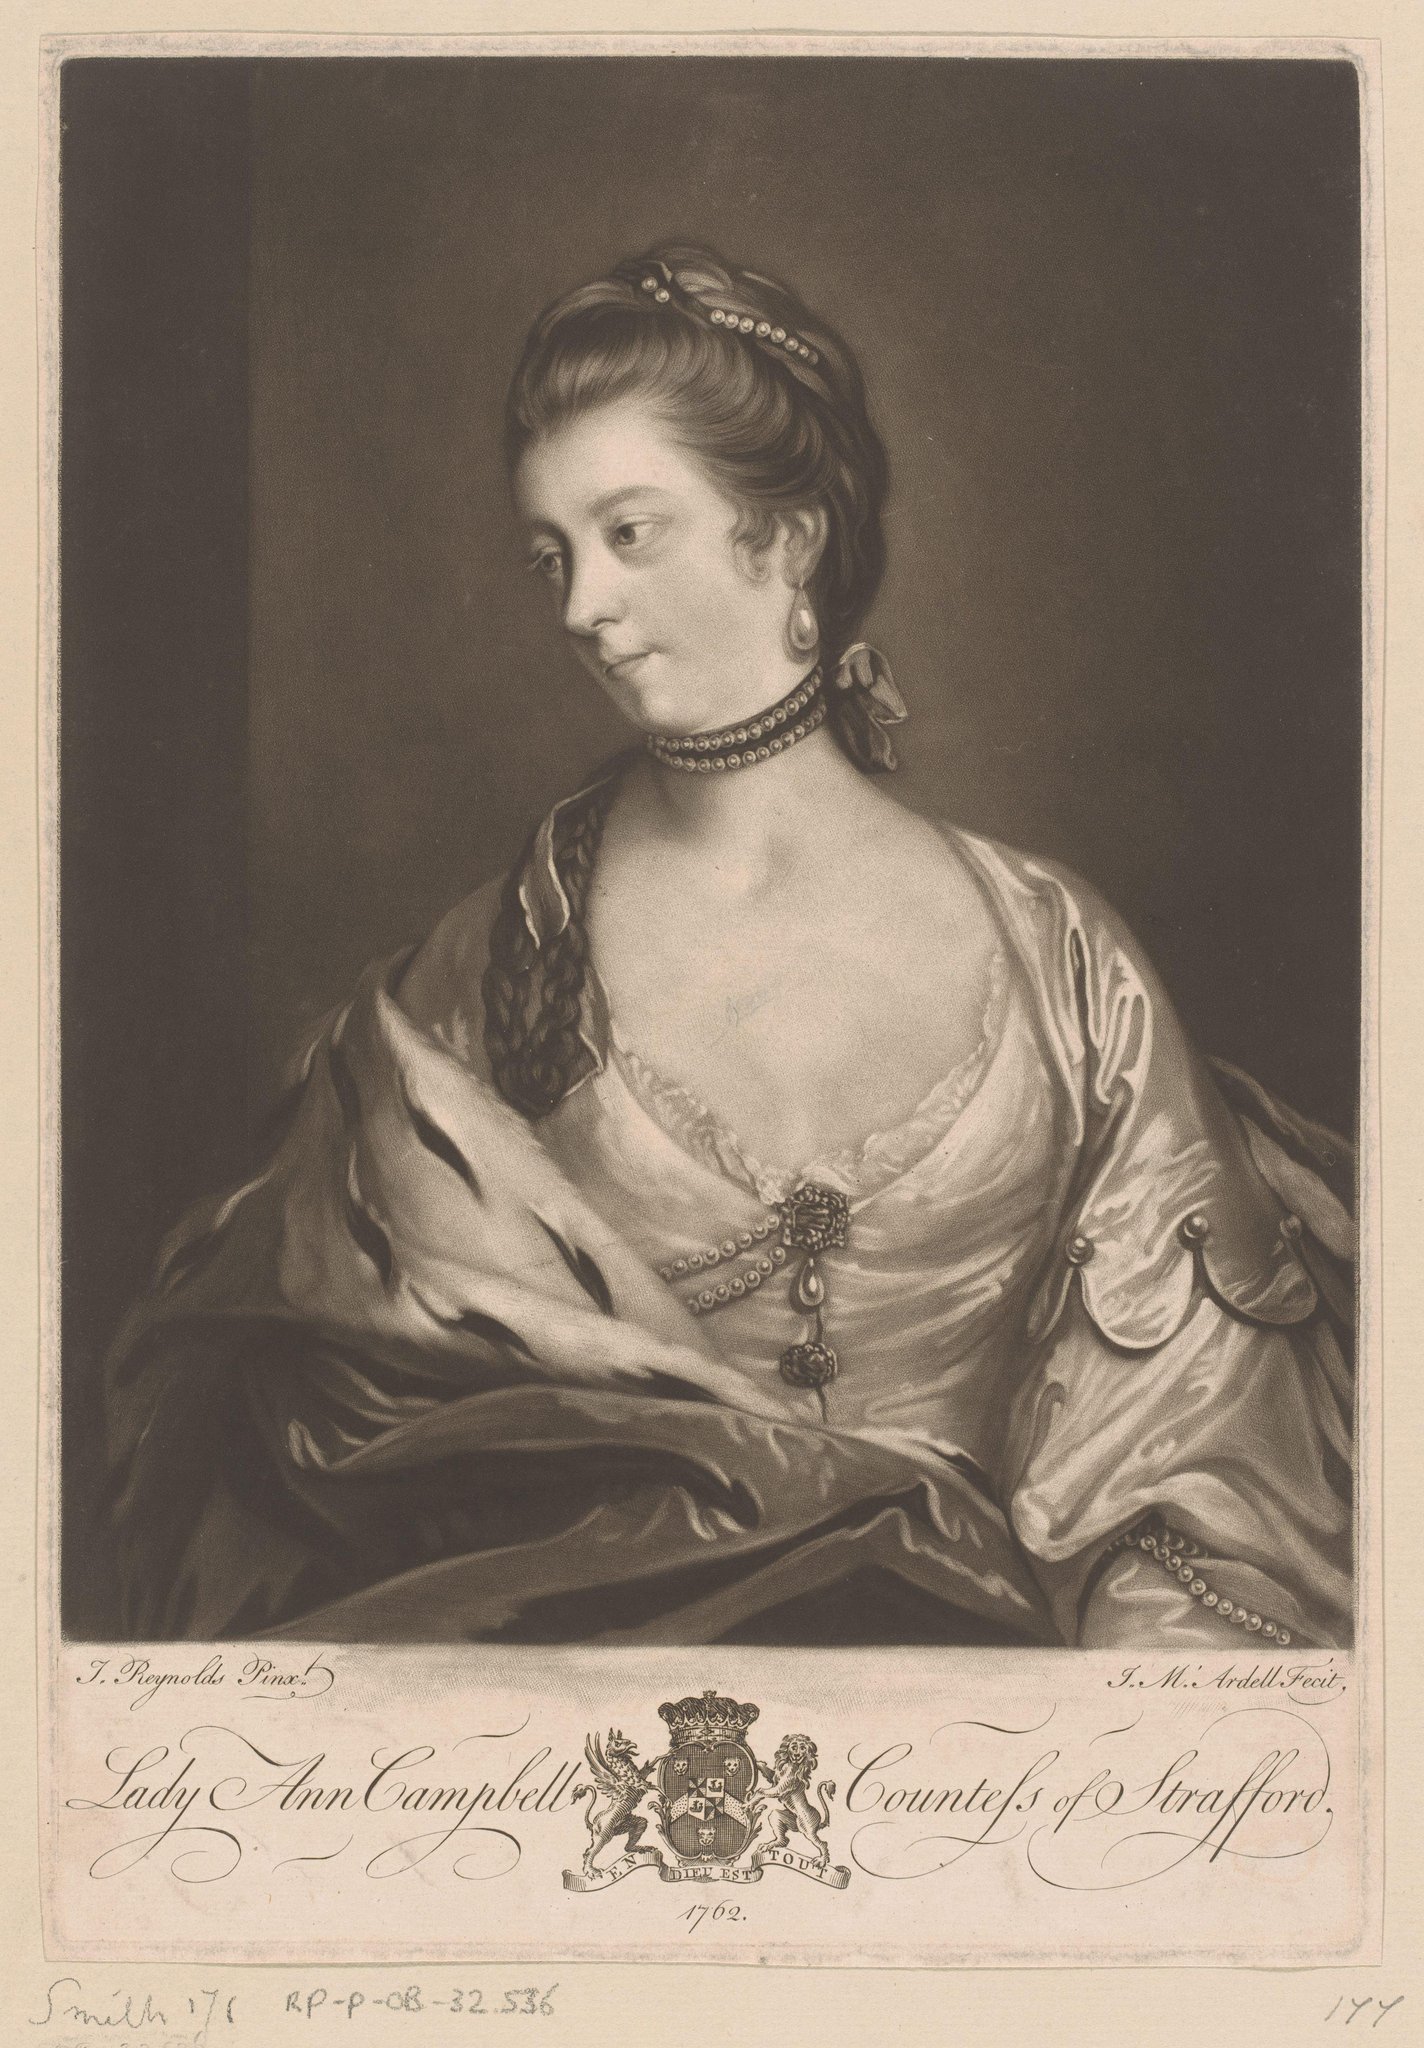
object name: print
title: Portret van Anne Campbell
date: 1762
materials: paper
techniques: mezzotint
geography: london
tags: historical persons - bb - woman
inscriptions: collector's mark: Lugt 240